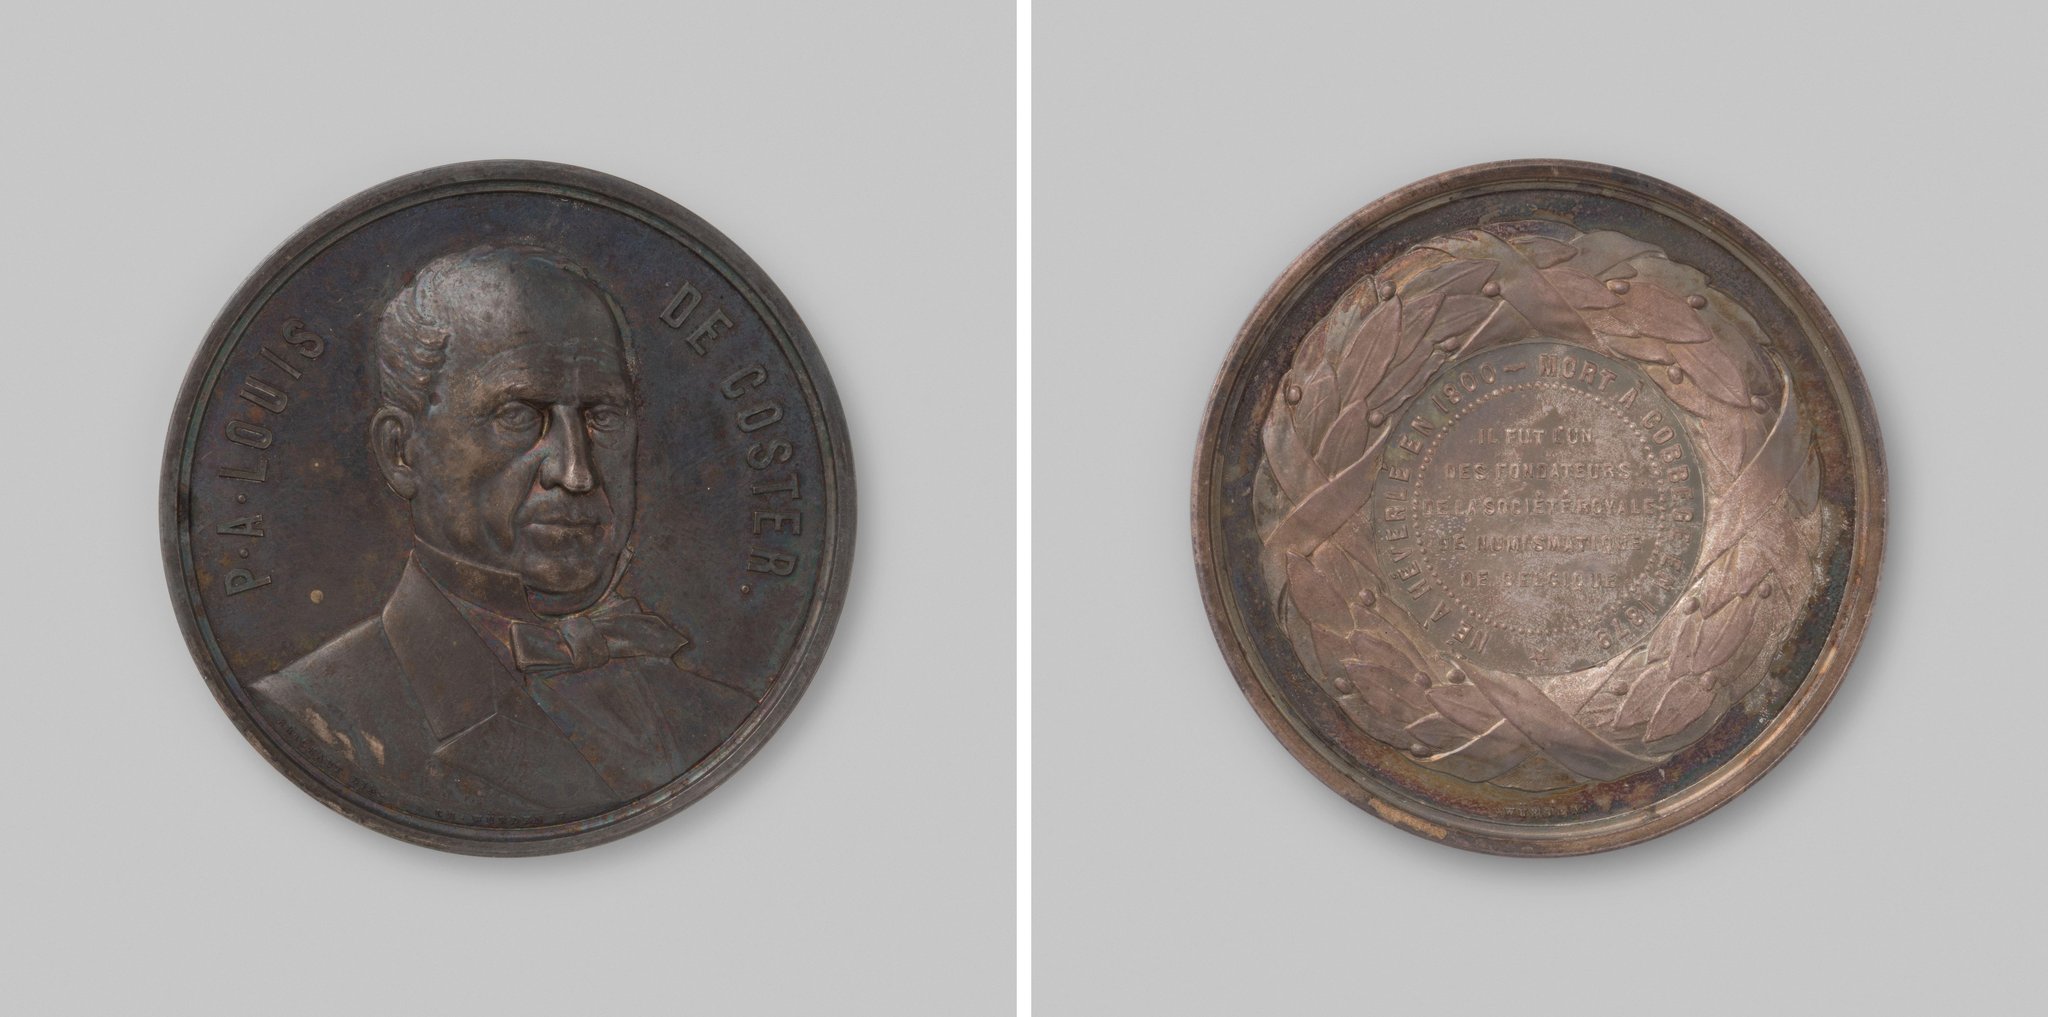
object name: history medal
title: Overlijden van P.A. Louis de Coster, medeoprichter van de Societe Royale de Numismatique de Belgique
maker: henri charles wurden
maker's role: medailleur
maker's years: 1847-1908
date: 1879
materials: silver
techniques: striking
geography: brussels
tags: p.a. louis de coster, société royale de numismatique de belgique, andenne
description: Zilveren penning. Voorzijde: borststuk man binnen omschrift. Keerzijde: opschrift binnen omschrift en lauwerkrans.